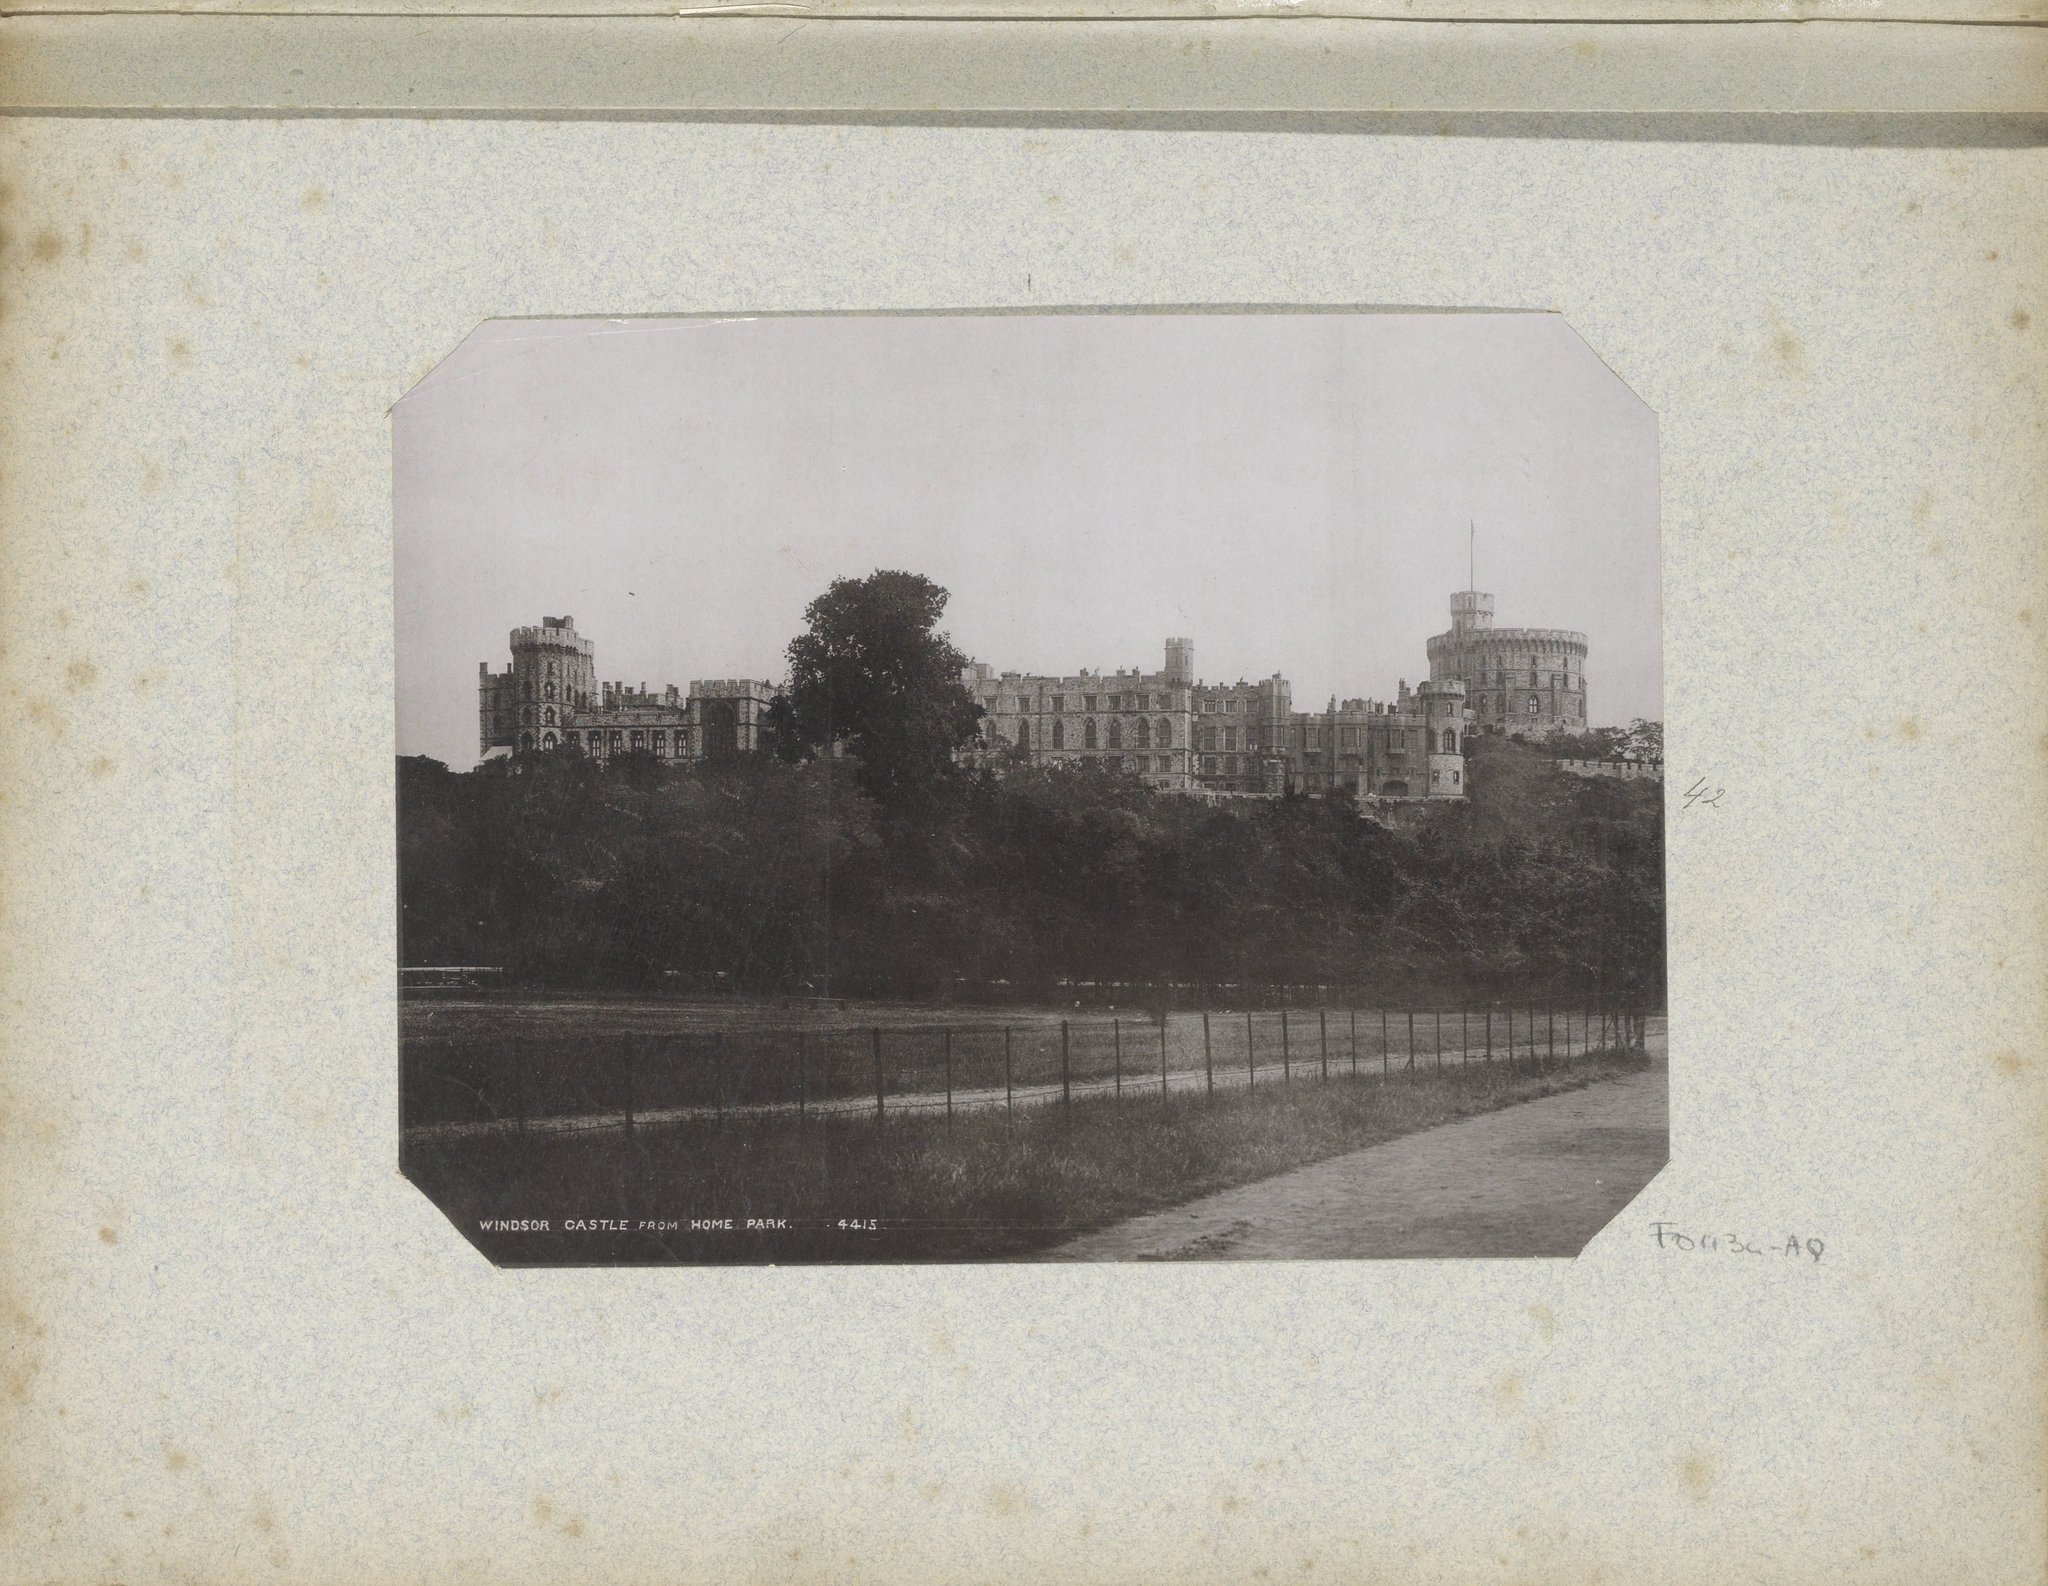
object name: album leaf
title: Windsor Castle from Home Park.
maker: Anonymous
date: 1880-1910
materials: paper, ink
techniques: photograph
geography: windsor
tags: palace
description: Onderdeel van Reisalbum met bezienswaardigheden in Engeland, Zwitserland, Frankrijk en Duitsland.